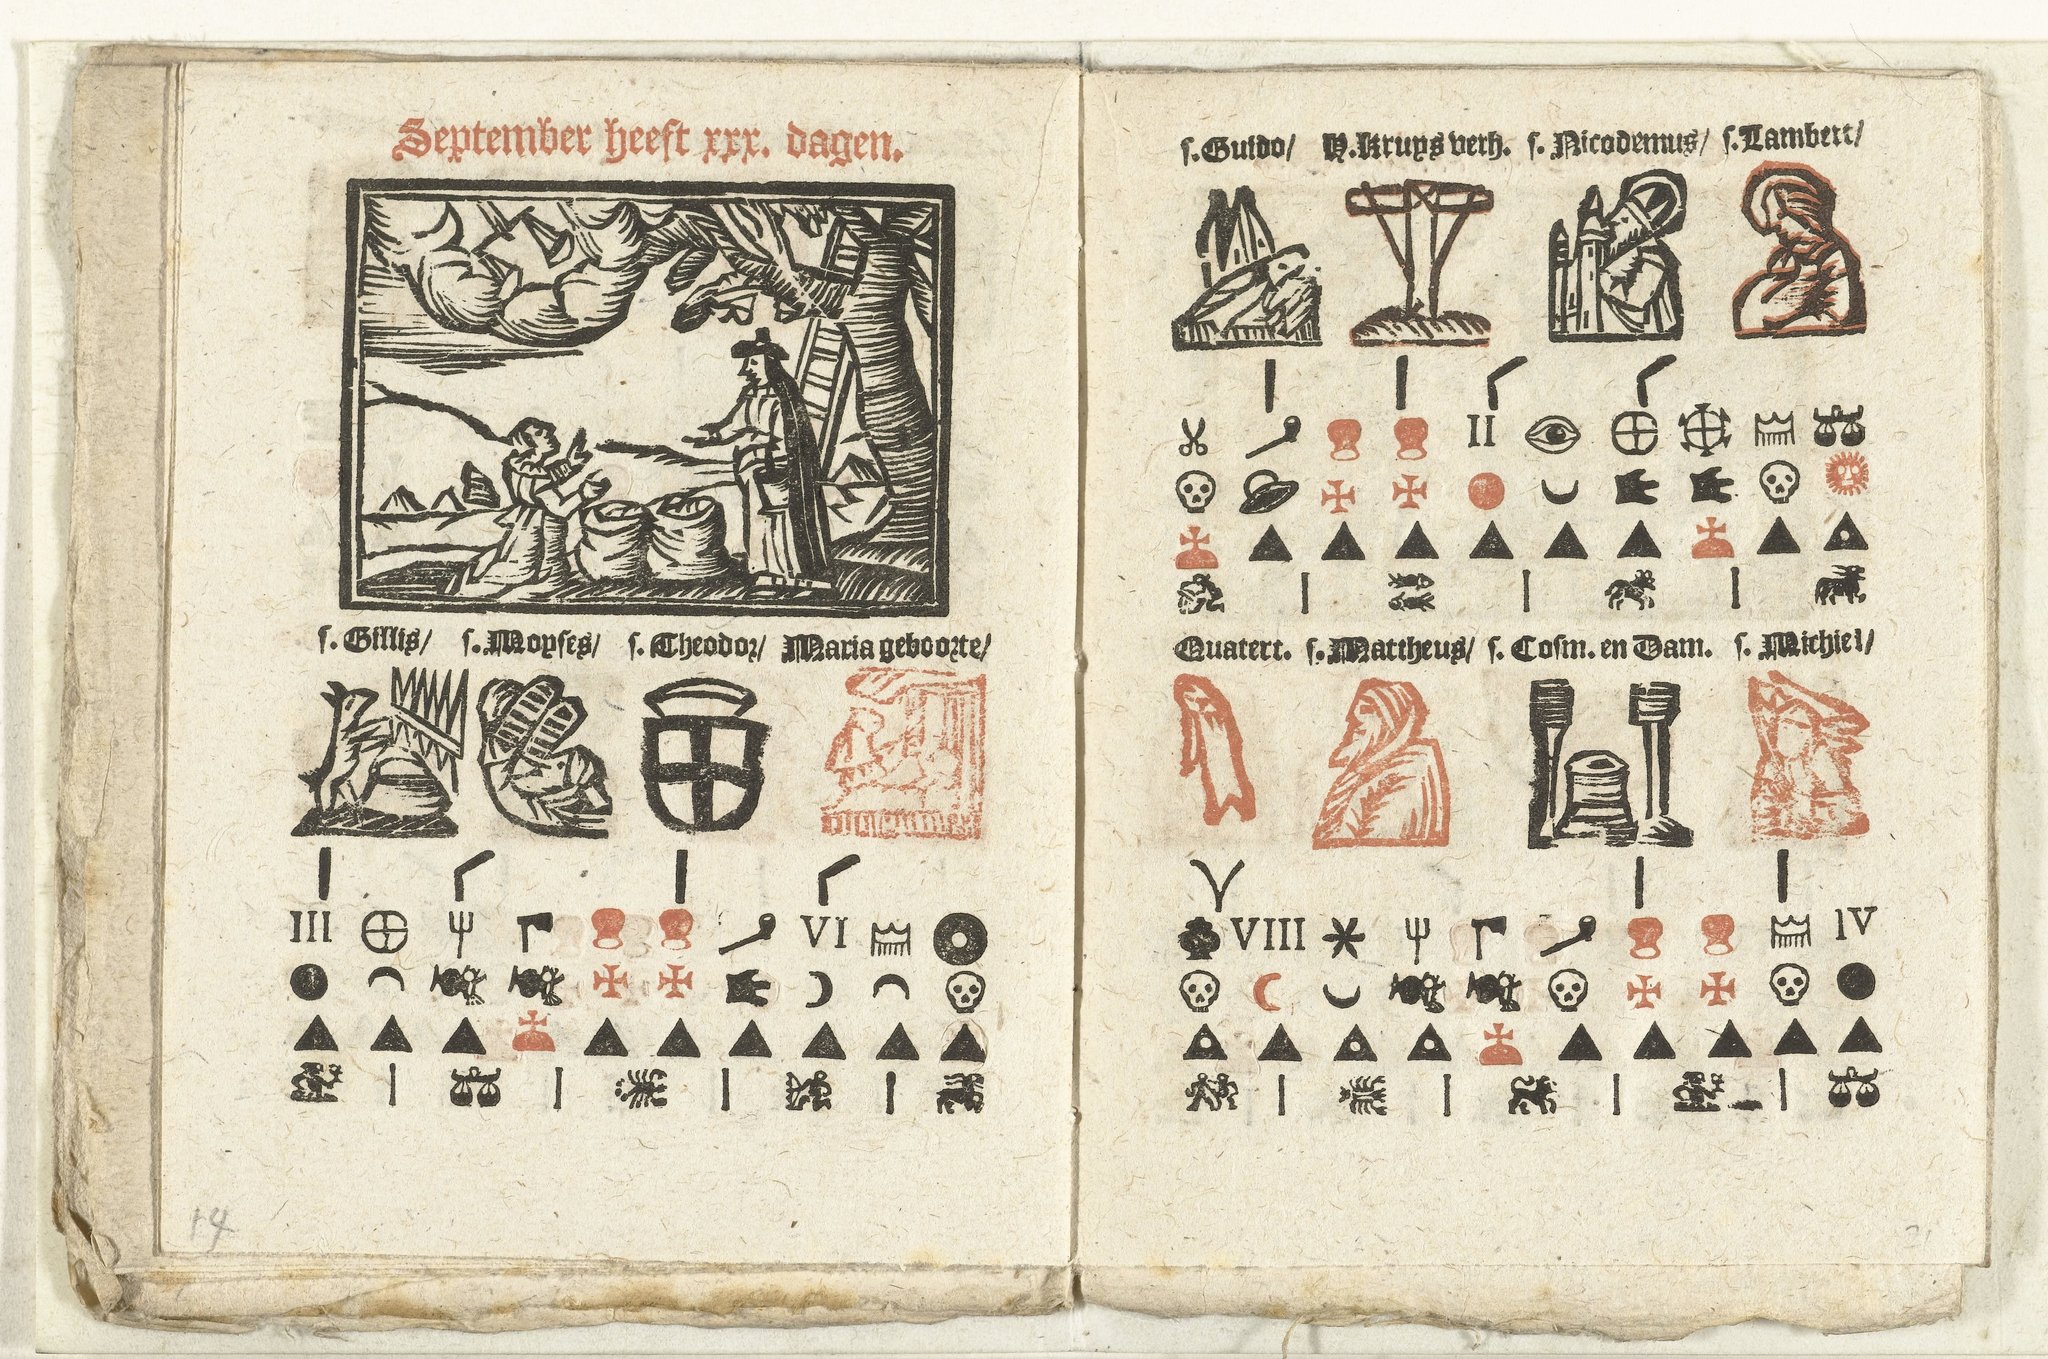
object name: print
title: Bladzijden met de voorspelling voor de maand september, 1712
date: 1712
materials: paper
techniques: letterpress printing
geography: antwerp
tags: september and its 'labours' (+ with zodiacal signs)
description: Bladzijden in: Den Boeren / Oft Schapers Almanach Voor 't Schrickel Jaer ins Heeren Jesu Christi, 1712. Antwerpen: bij Wed. Slegers 1712. Exemplaar in de Rijksmuseum Research Library (signatuur: 305 G 19).